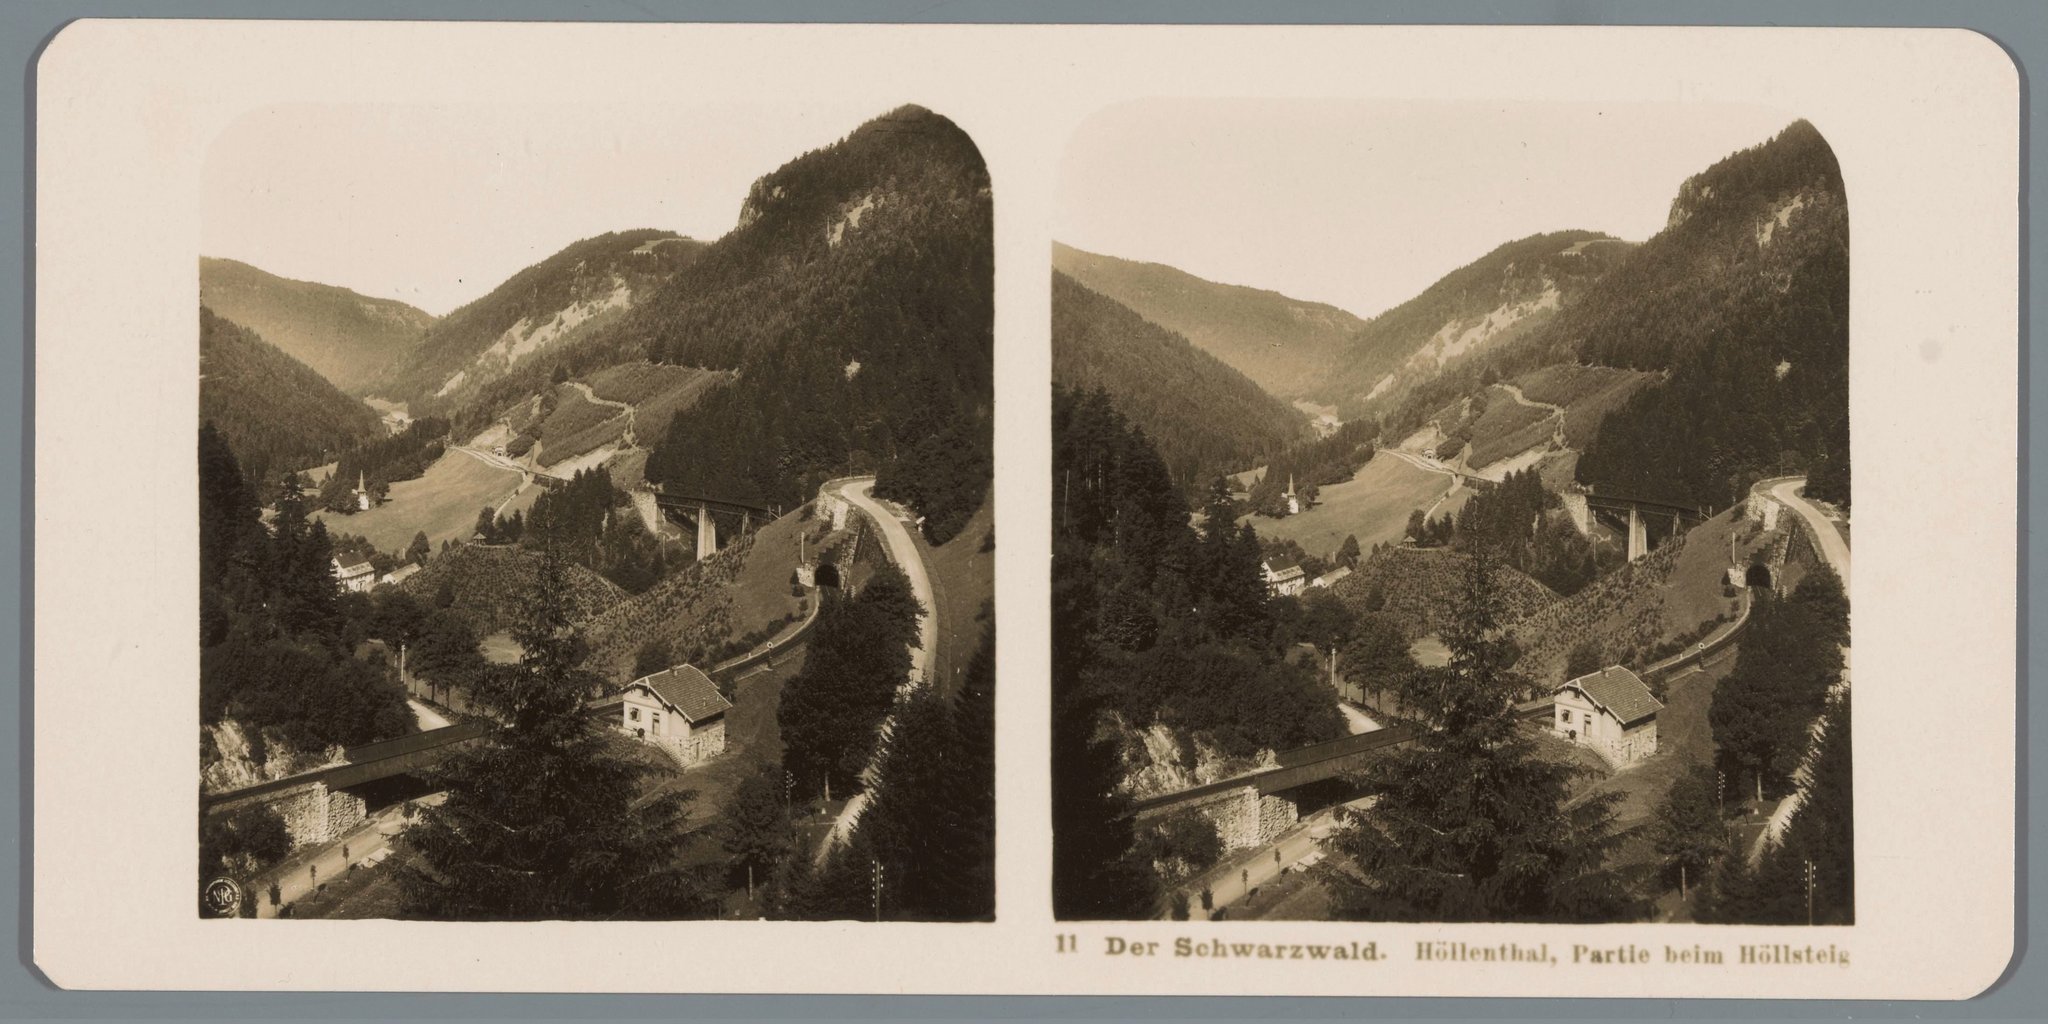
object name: stereograph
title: Gezicht op het Höllental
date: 1900-1910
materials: cardboard, photographic support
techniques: gelatin silver print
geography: höllental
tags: dale, valley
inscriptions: inscription: ‘NPG’, number: ‘11’